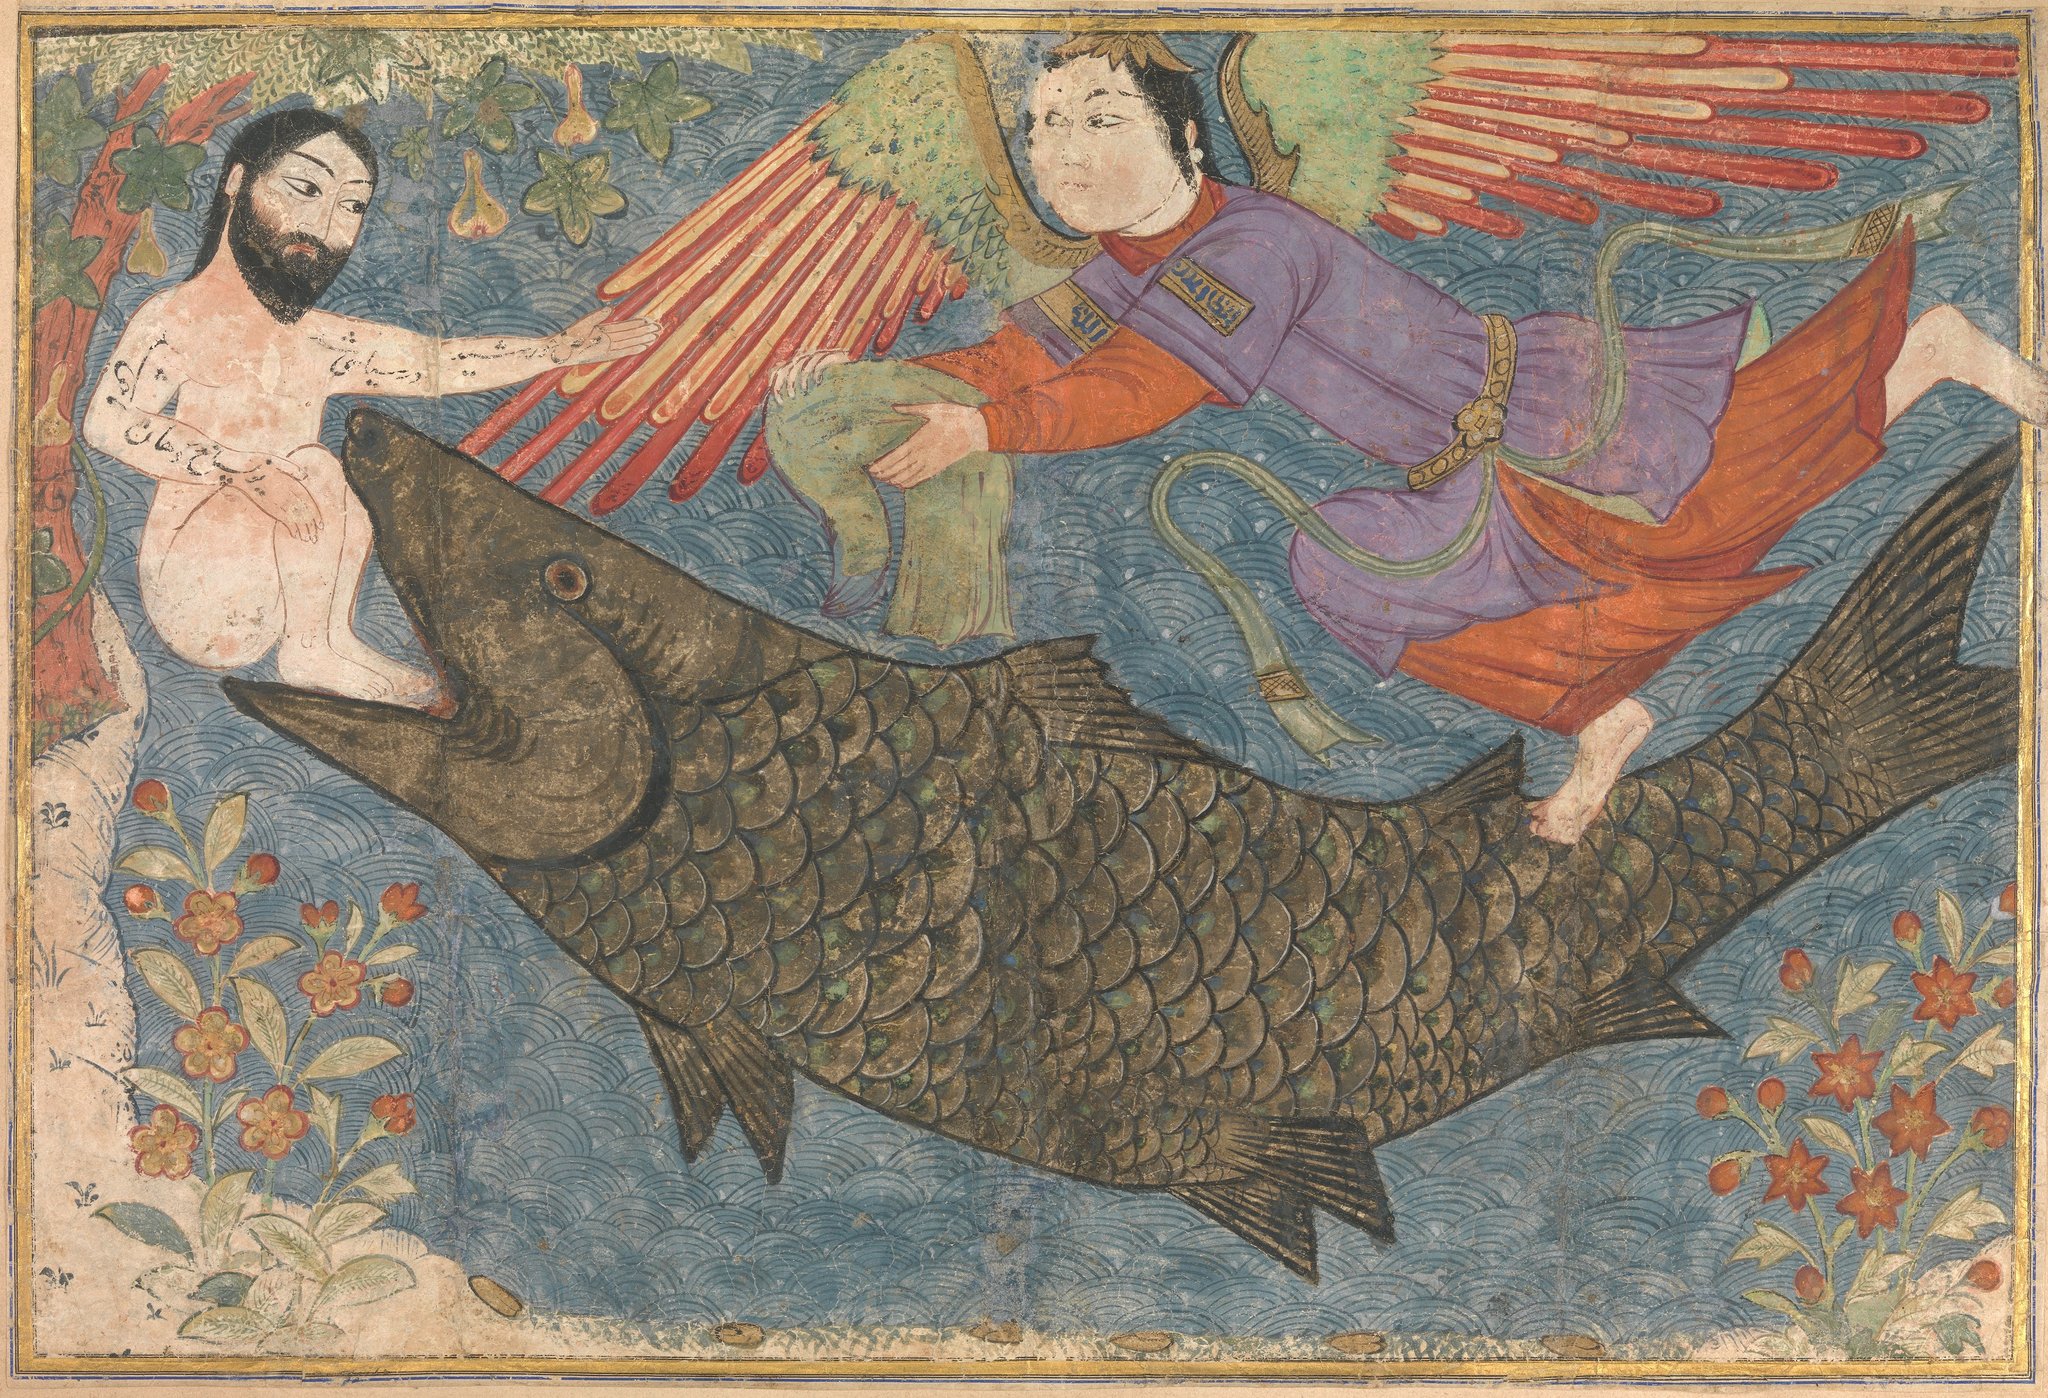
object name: folio from an illustrated manuscript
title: "Jonah and the Whale", Folio Probably from a Jami al-Tavarikh (Compendium of Chronicles)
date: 1400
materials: gold, ink, paper, silver, watercolor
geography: iran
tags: men,whales,angels